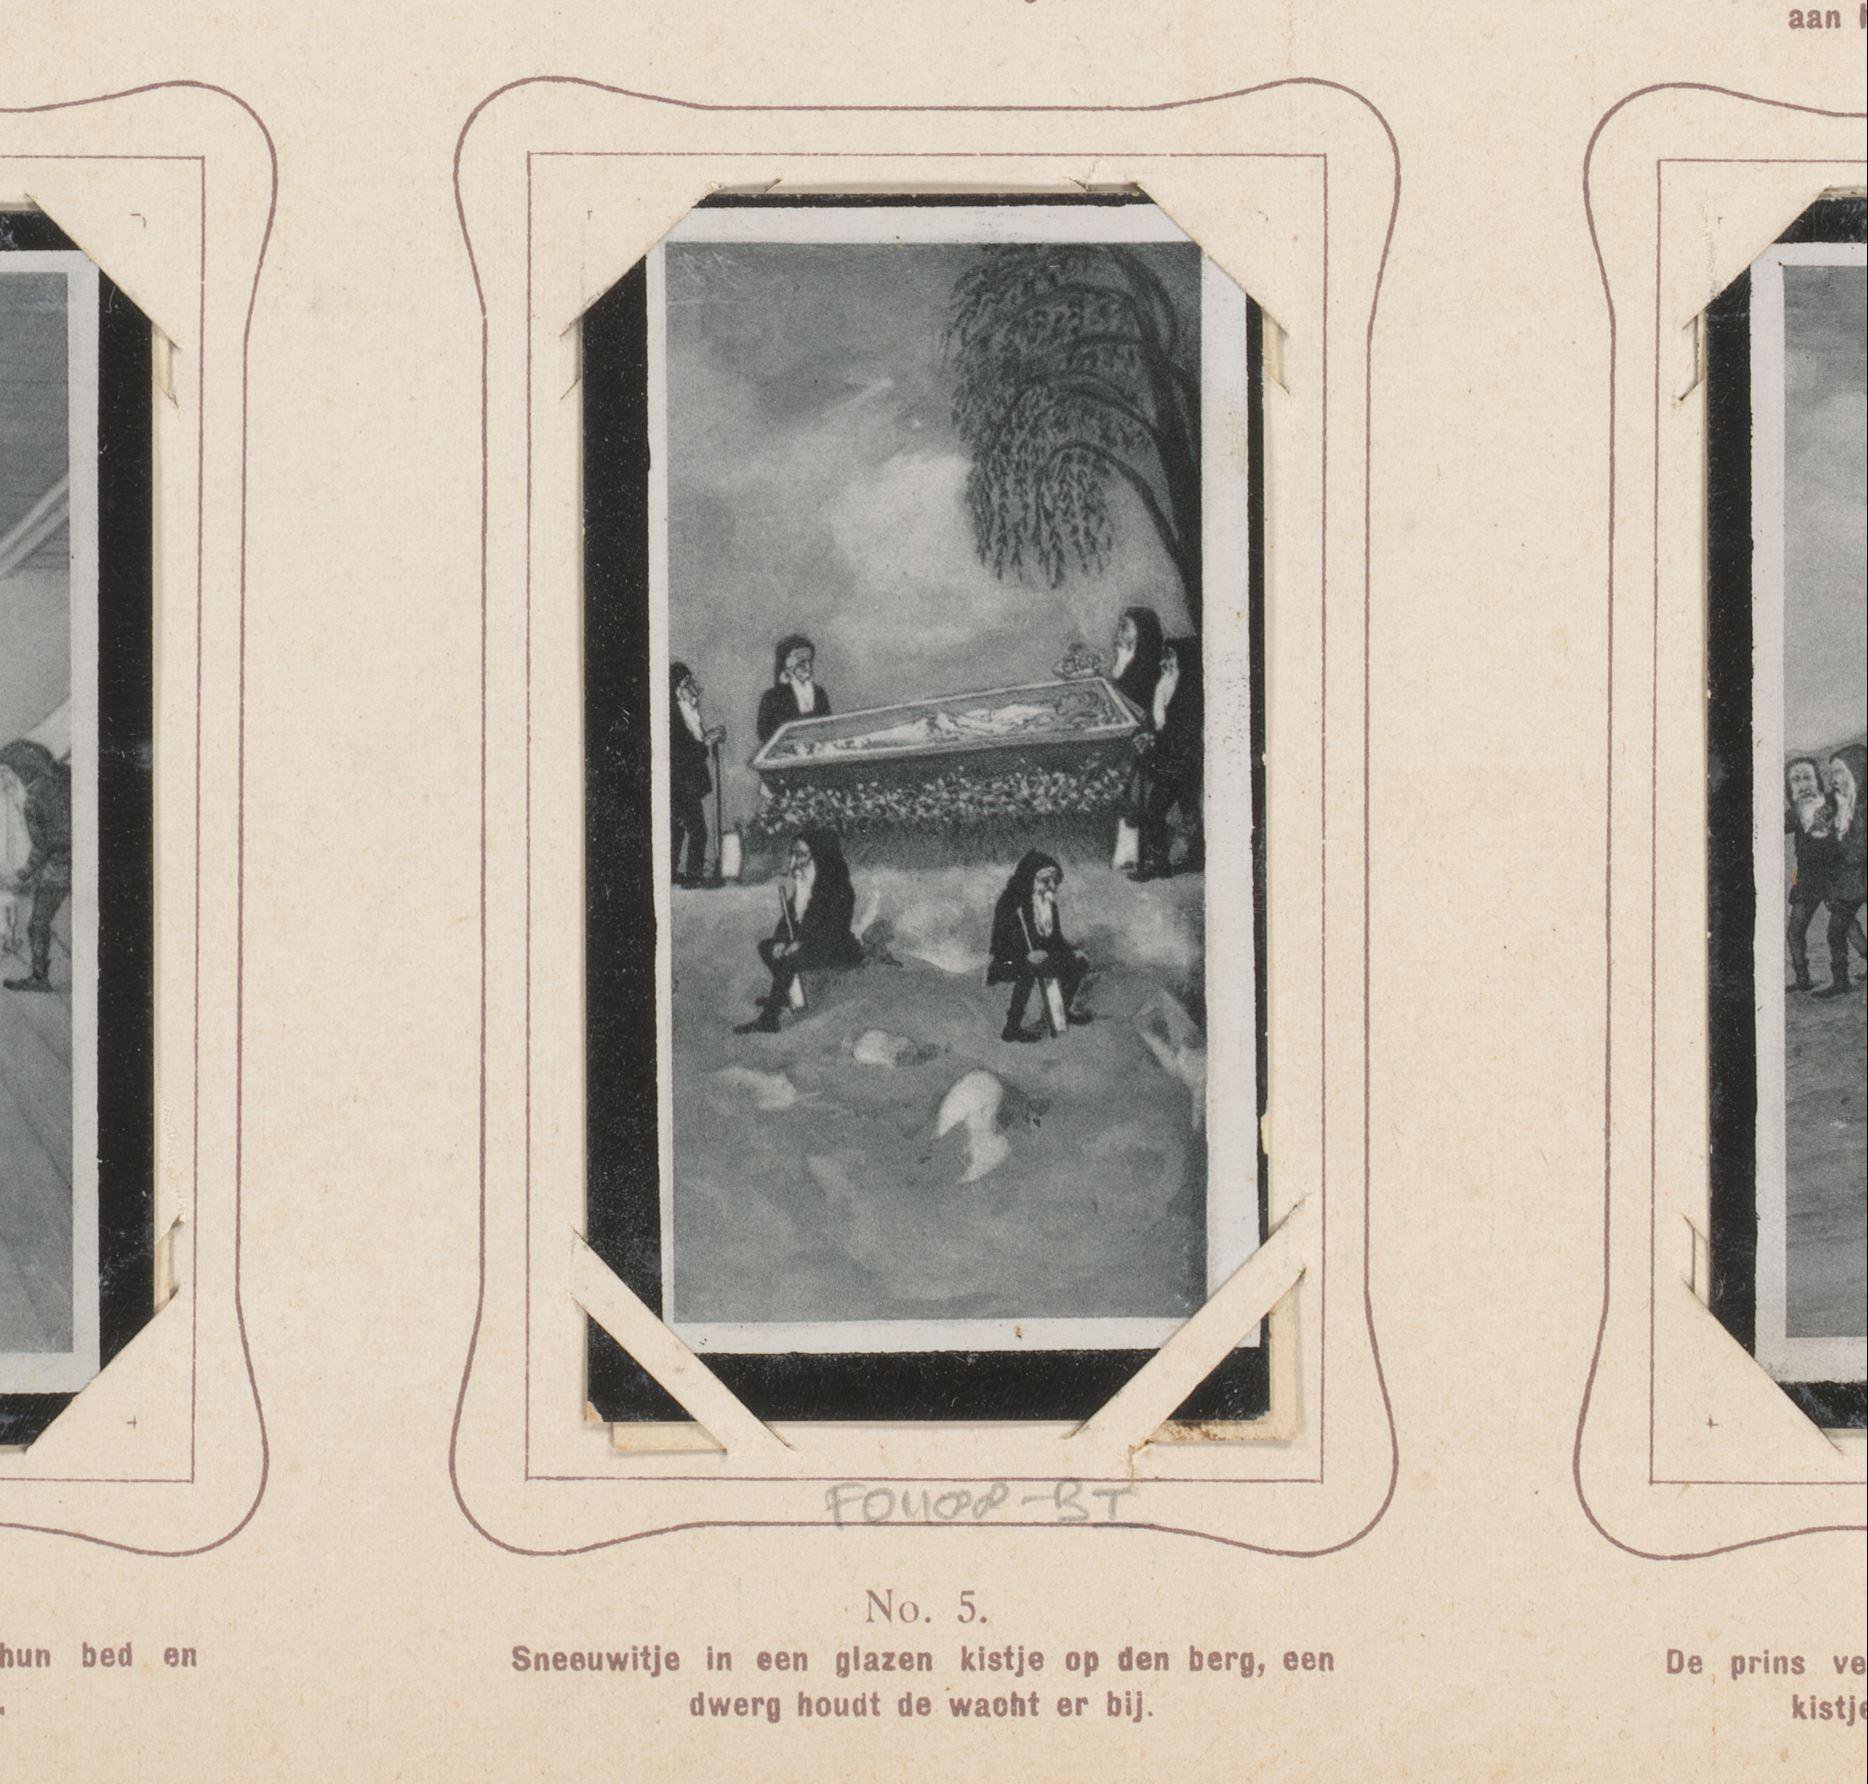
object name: photomechanical print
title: Sneeuwwitje wordt begraven door de zeven dwergen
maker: Anonymous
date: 1906-1907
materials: paper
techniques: photograph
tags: tales and fairy tales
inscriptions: inscription: ‘No. 5./ Sneeuwitje in een glazen kistje op den berg, een dwerg houdt de wacht er bij.’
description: Deze prent maakt deel uit van een album.